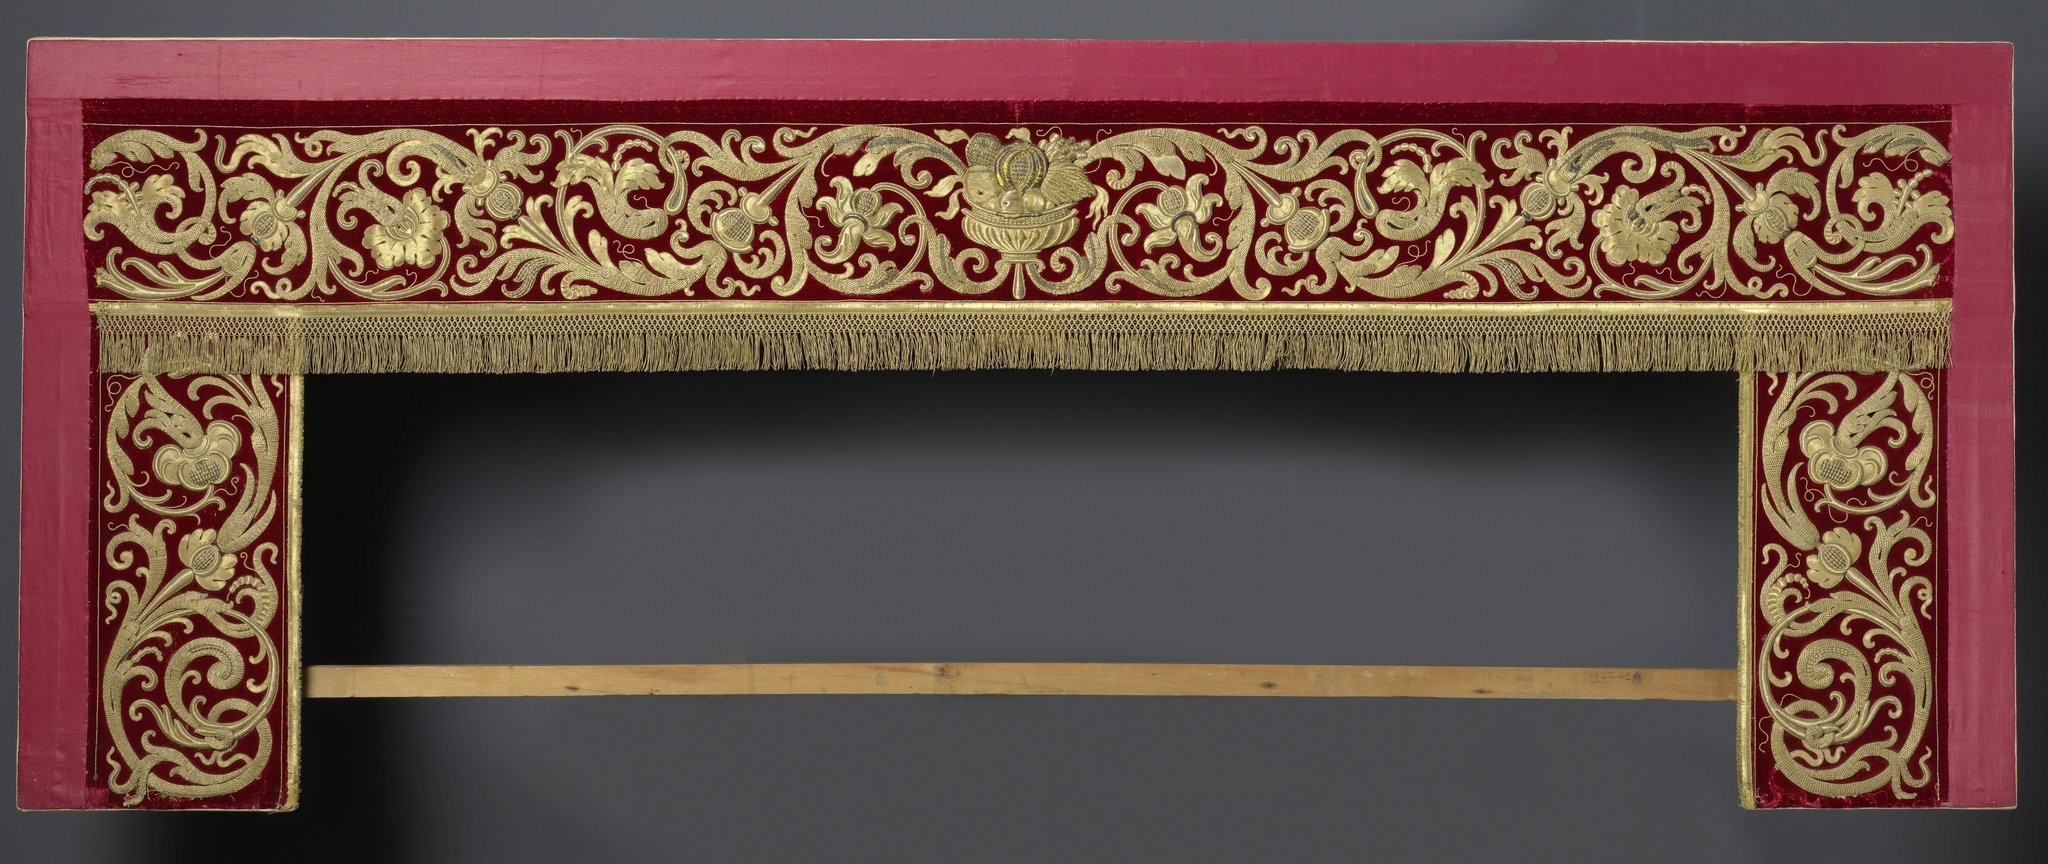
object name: antependium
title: Antependium van goudbrokaat en borduurwerk in gouddraad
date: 1700-1725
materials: gold thread, velvet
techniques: brocade, embroidered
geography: france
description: Antependium met borduurwerk. De antependium heeft langs de bovenrand en langs de zijkanten een aurifries met een patroon van symmetrische spiraalranken waaraan om en om een bloem en een blad. De antependium hoort bij negen kerkelijke weefsels met borduurwerk met invnrs. BK-1972-1-A t/m BK-1972-1-I en een niet bijbehorende beurs met invnr. BK-1972-1-J.